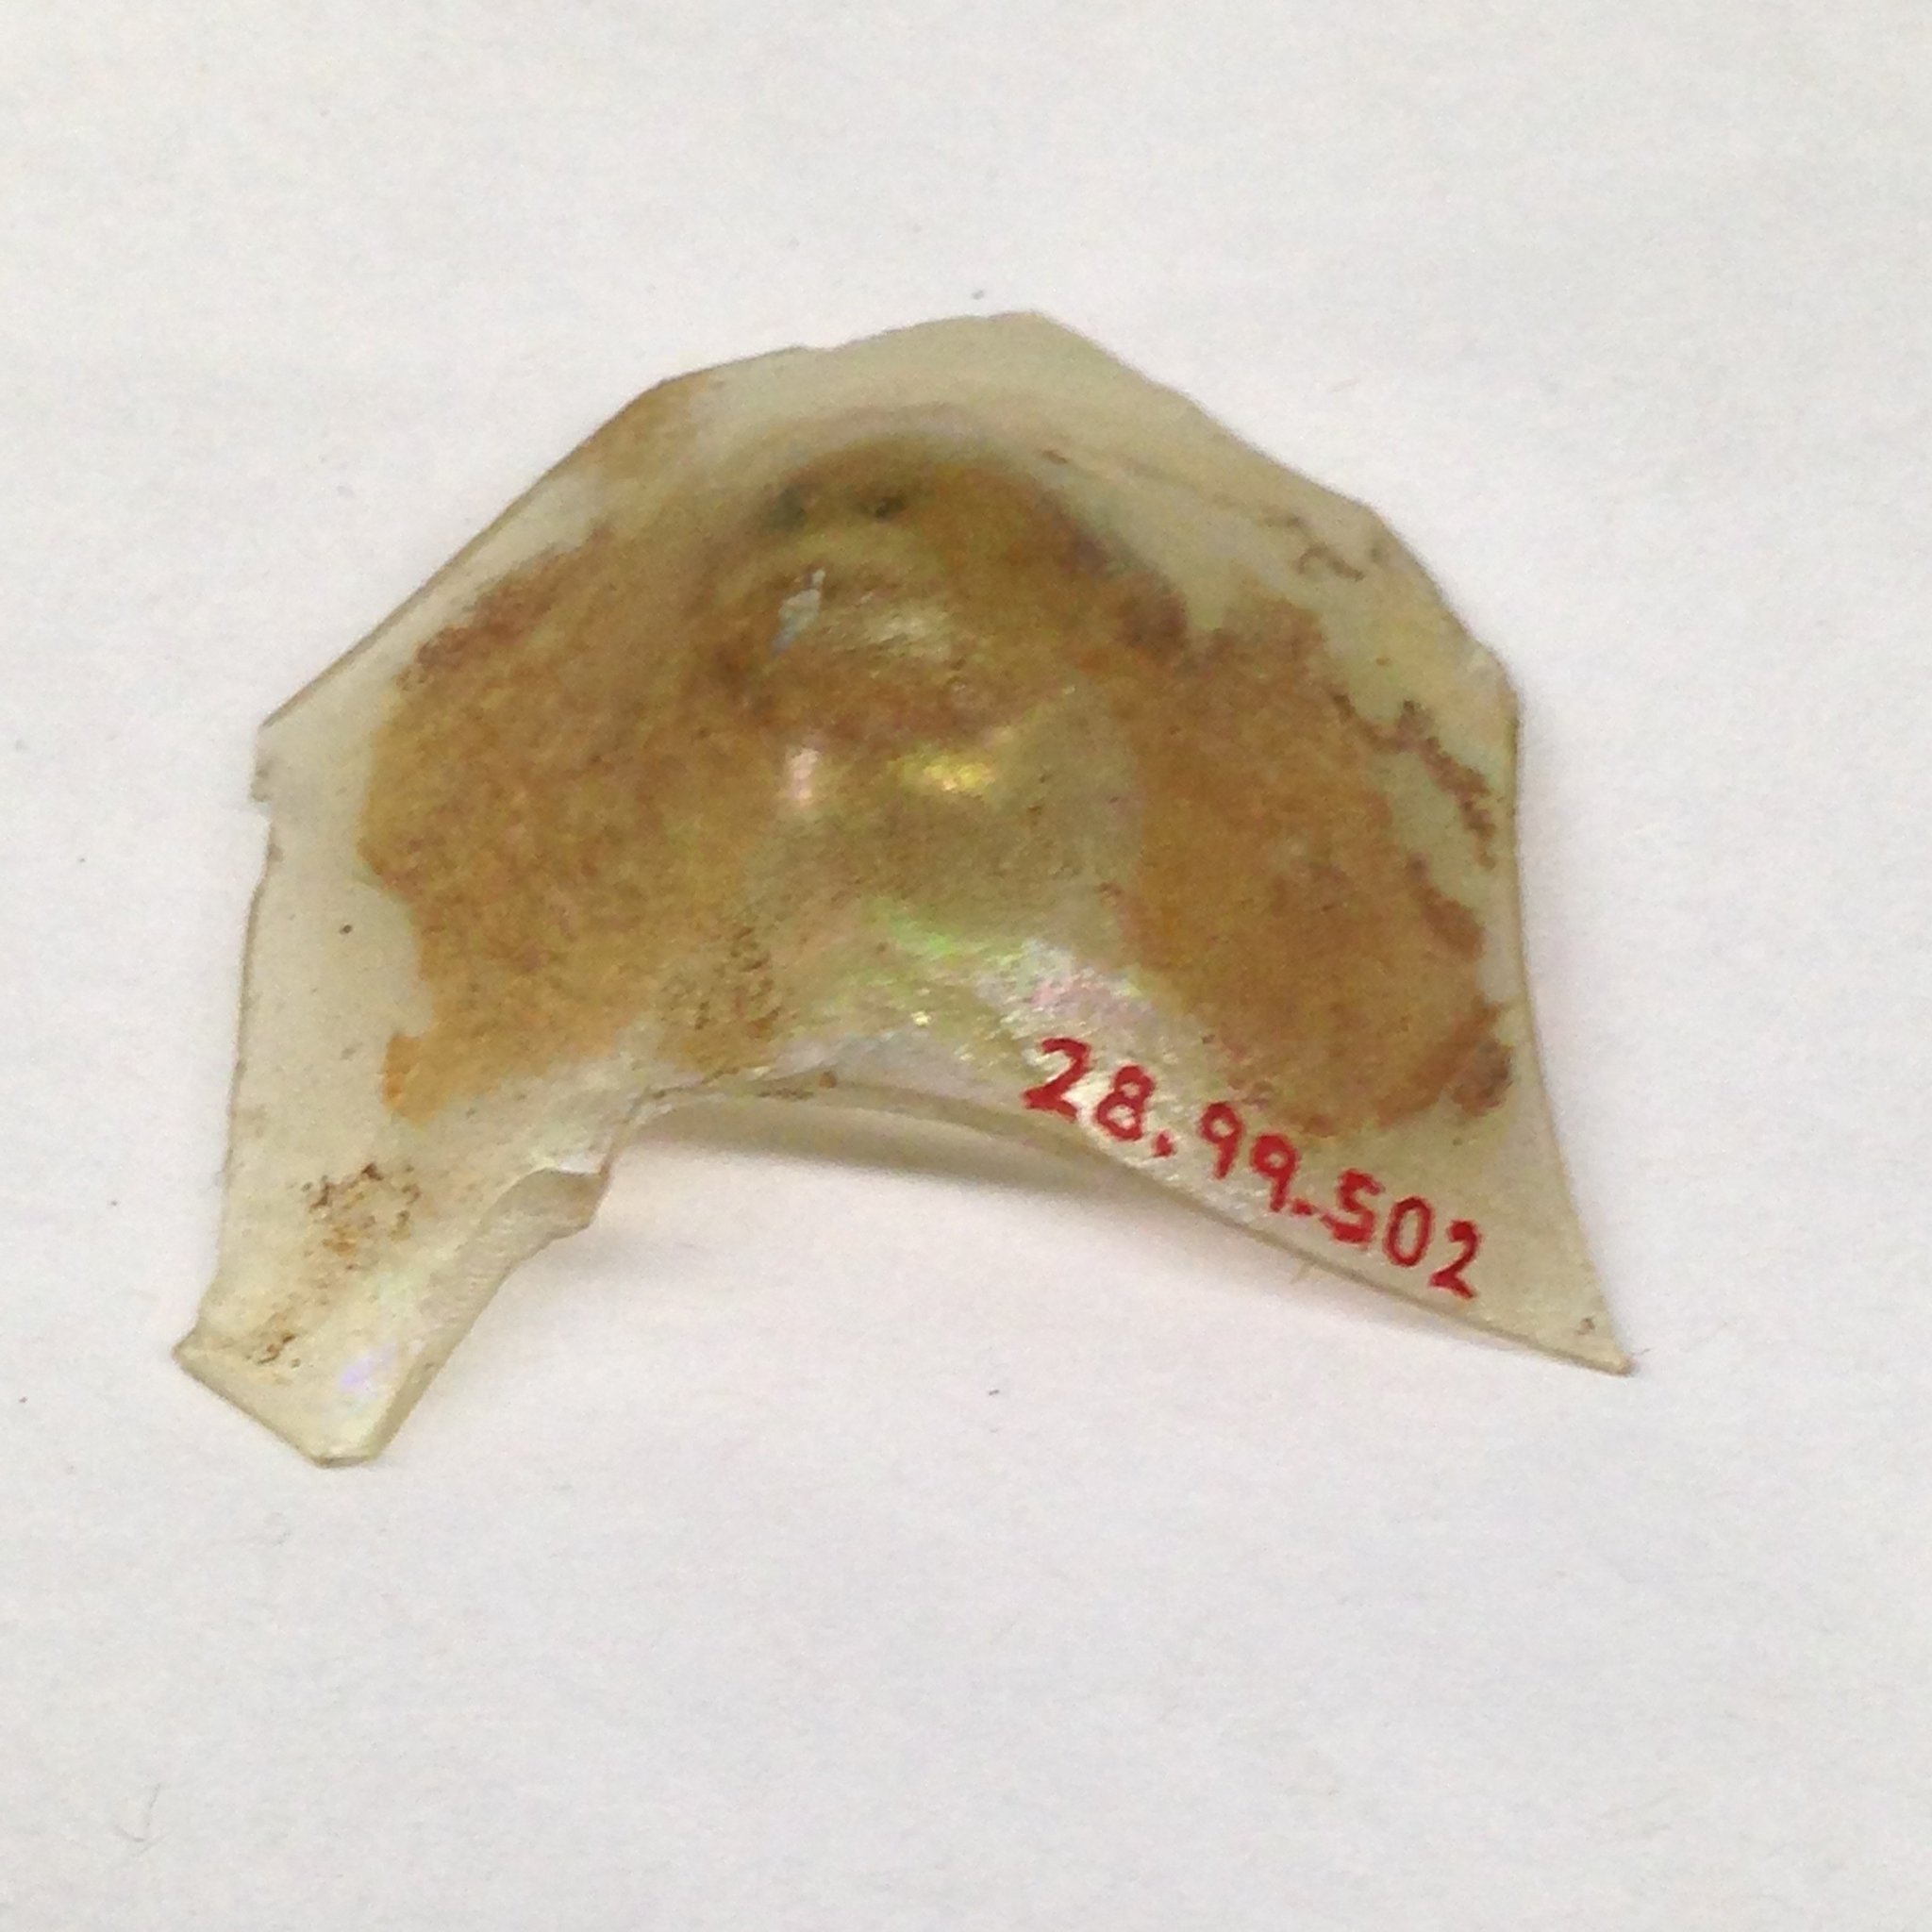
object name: fragment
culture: european or middle eastern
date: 1150-1250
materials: ceramic, glass